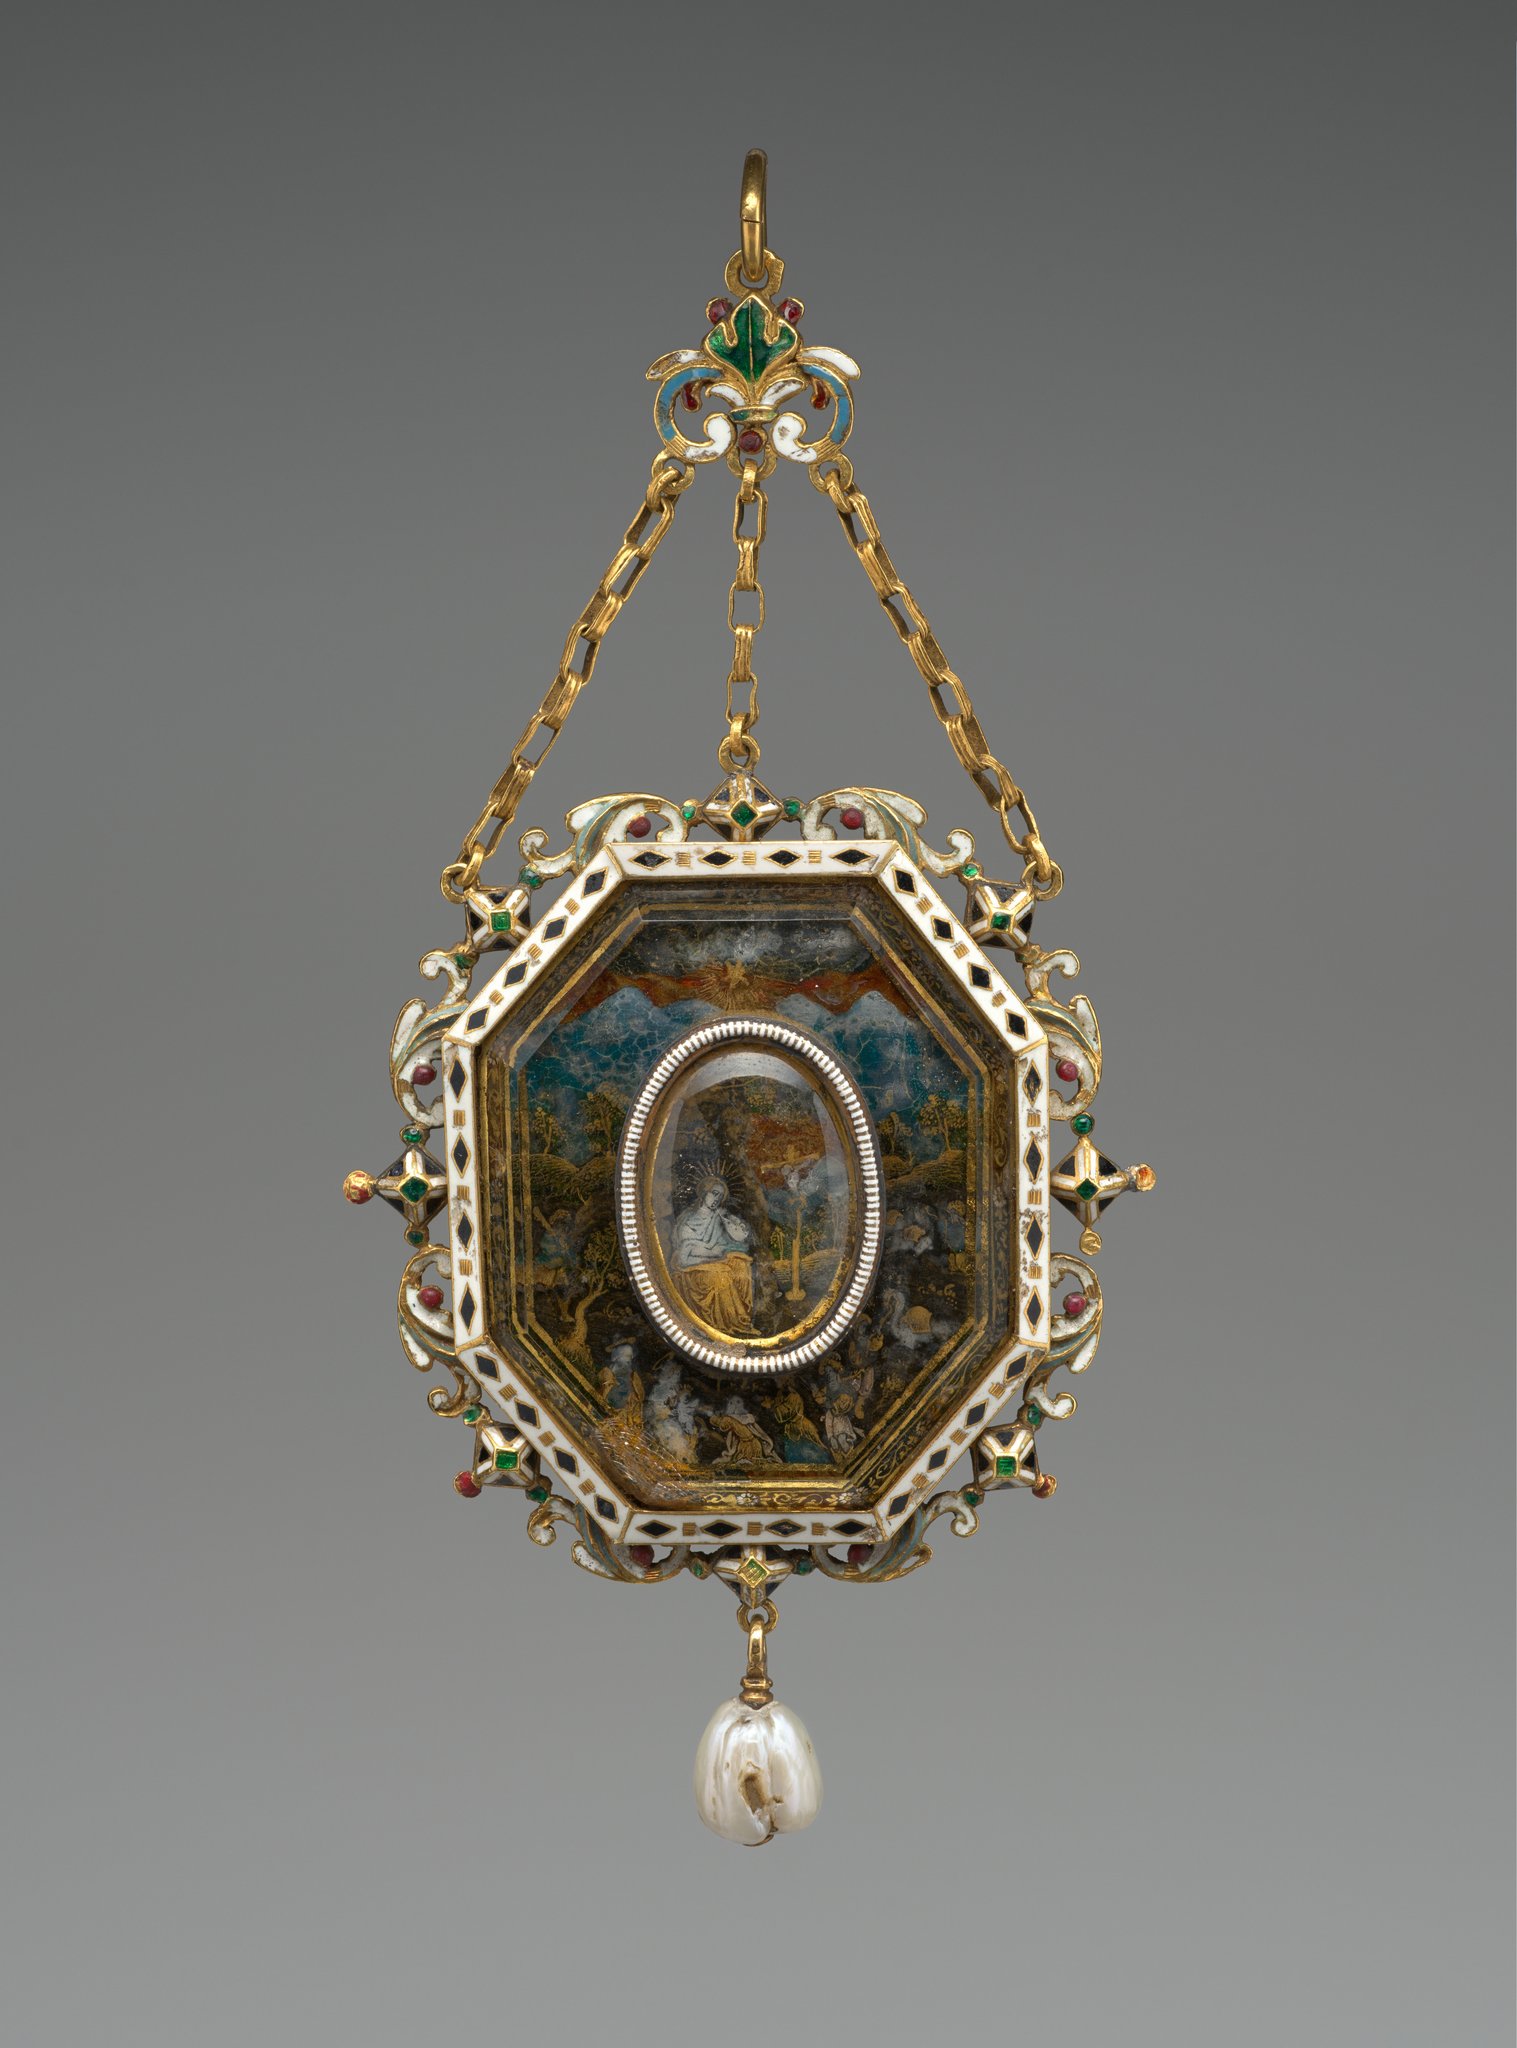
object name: pendant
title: Pendant with Scenes from the Life of Christ and Two Saints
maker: reinhold vasters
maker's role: designer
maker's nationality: german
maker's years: 1827-1909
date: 1870-1895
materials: gold, pearl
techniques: enamel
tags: christ,saints